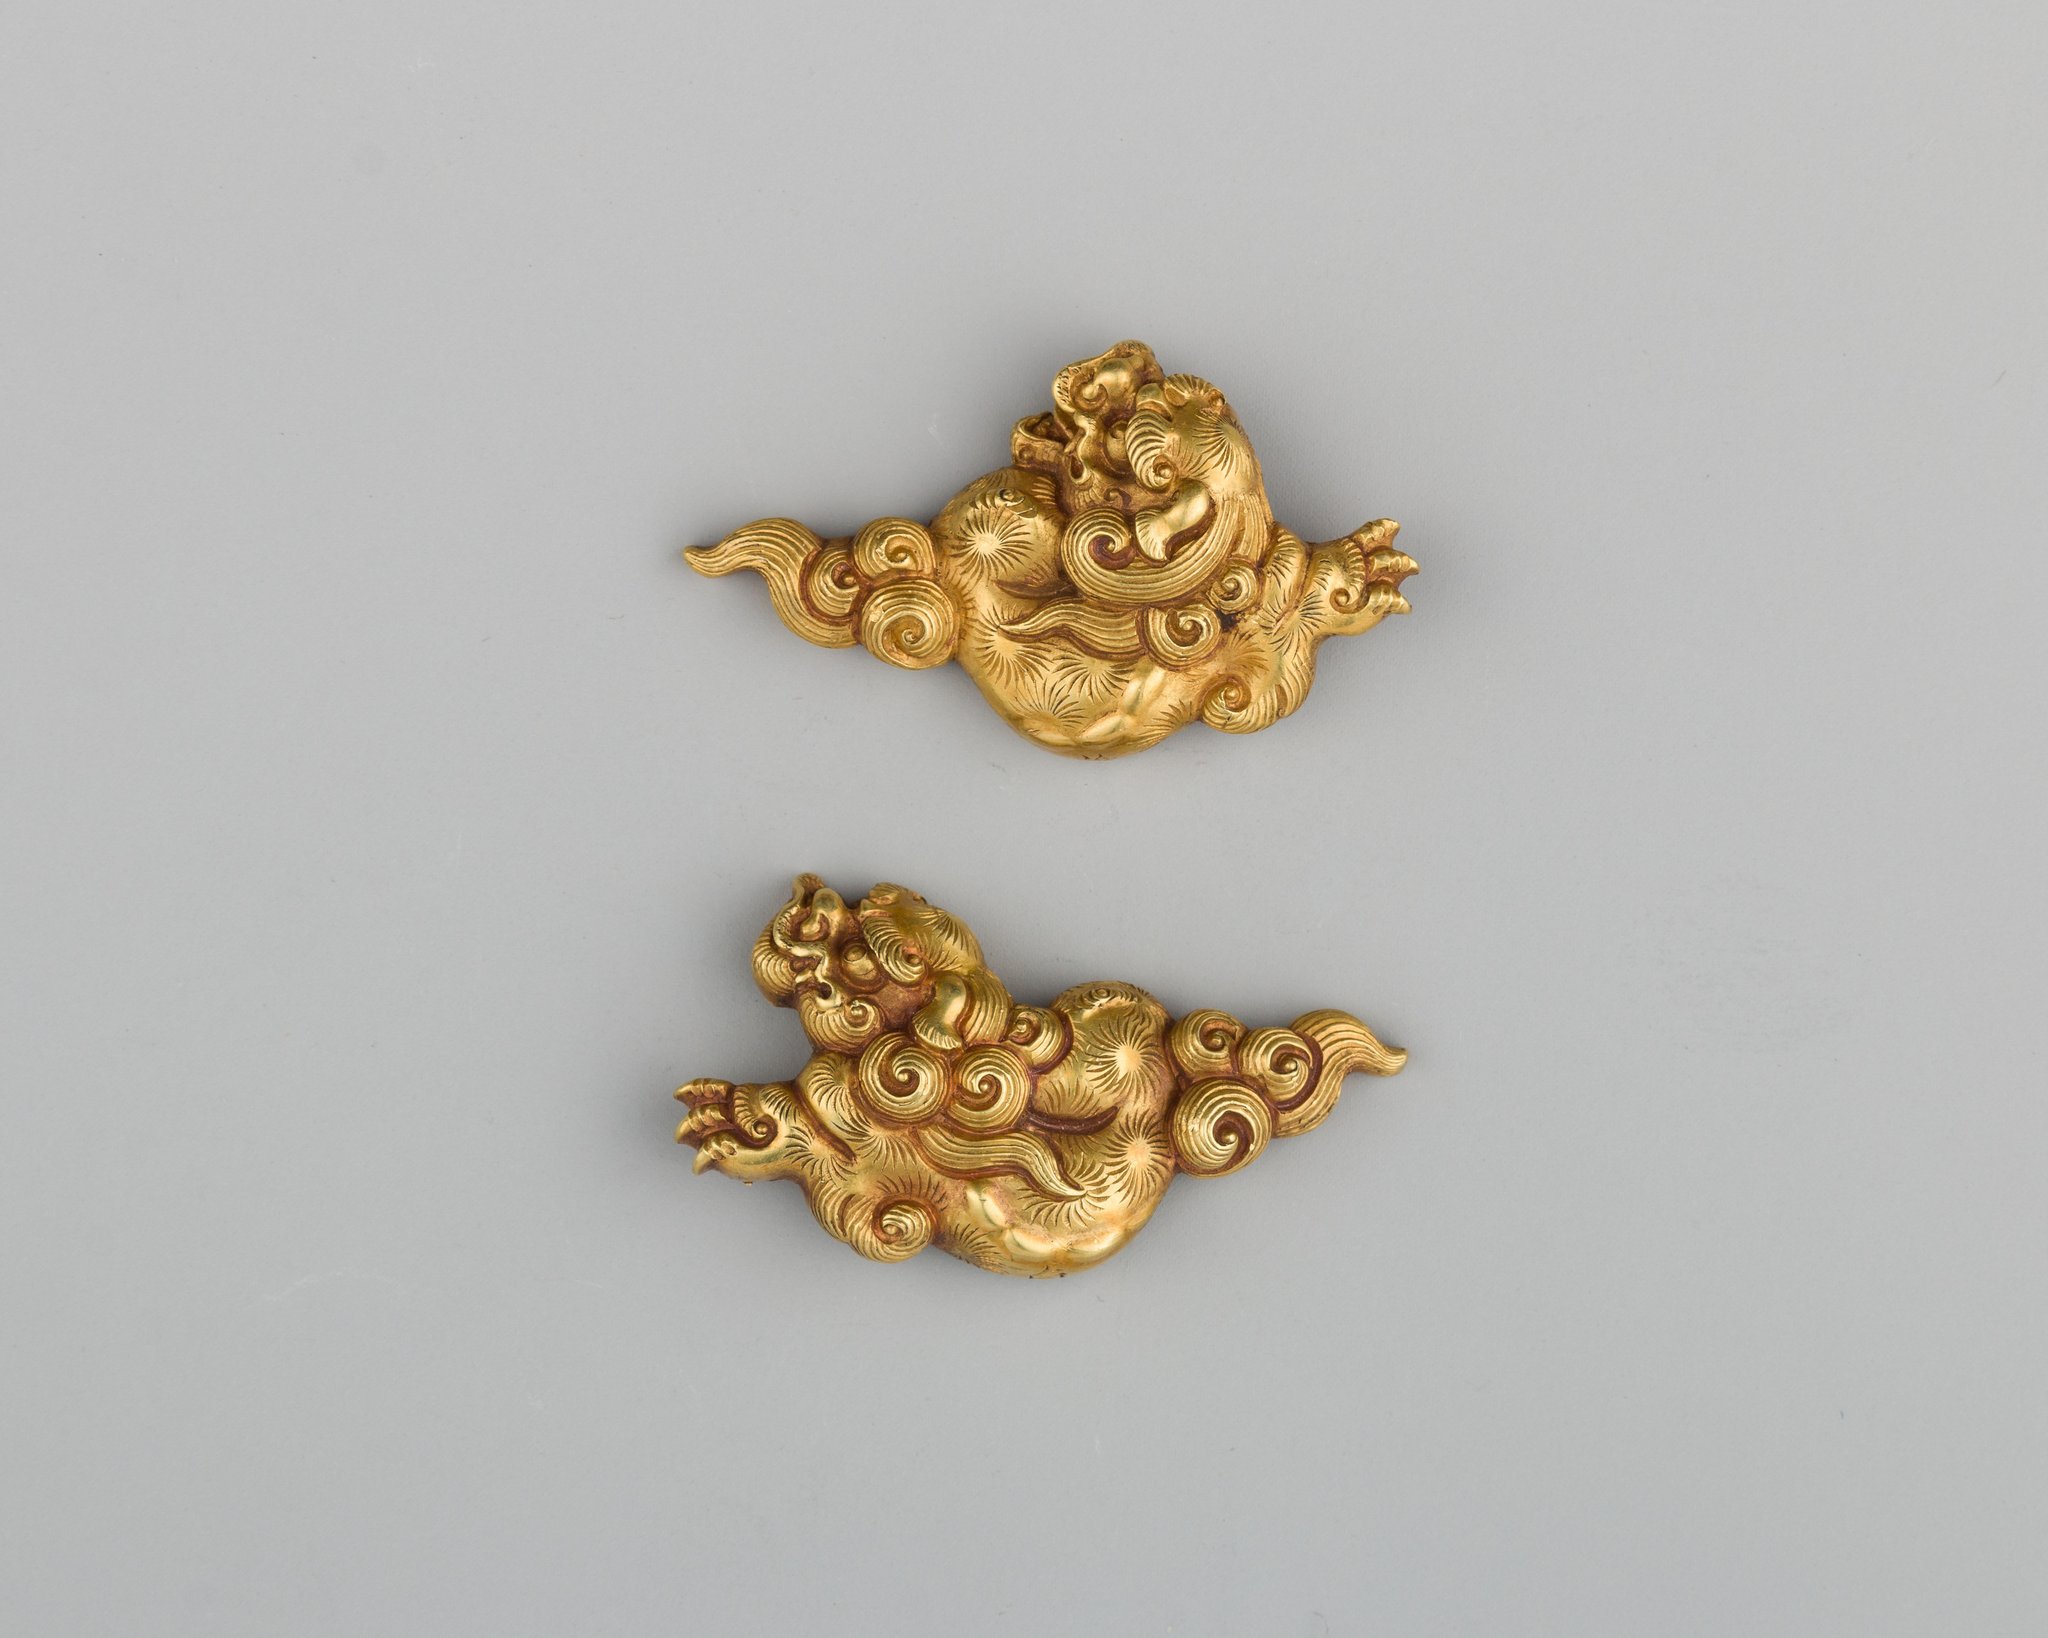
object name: pair of sword grip ornament menuki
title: Pair of Sword-Grip Ornaments (Menuki)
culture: japanese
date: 1701-1800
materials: gold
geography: japan